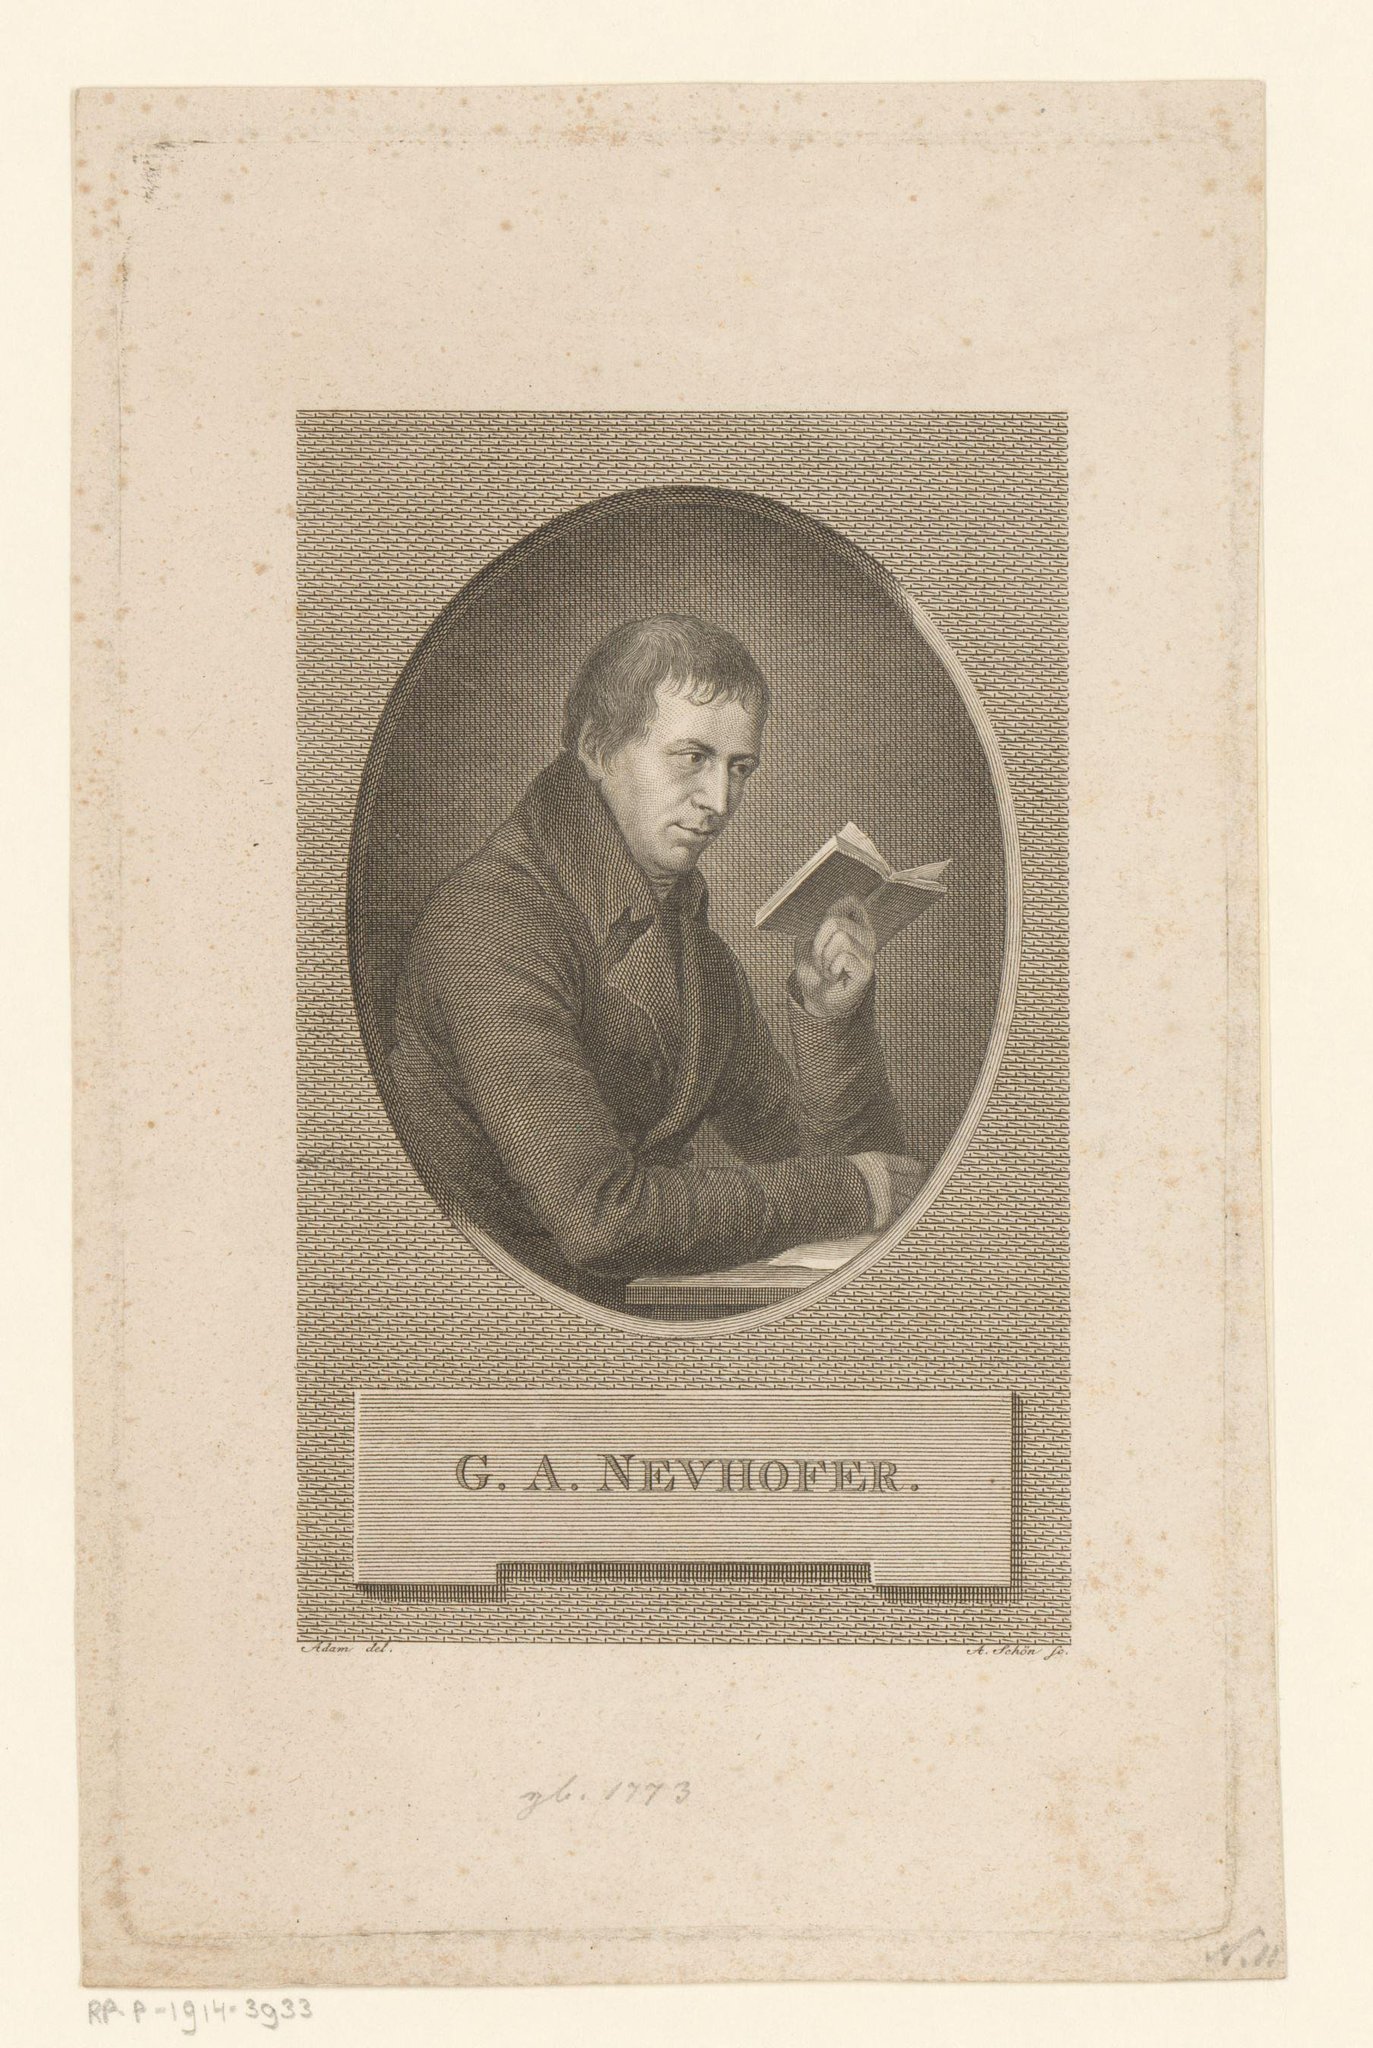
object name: print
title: Portret van Gerhard Adam Neuhofer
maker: alois schoen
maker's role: draughtsman, print maker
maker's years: -1820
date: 1720-1820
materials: paper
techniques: engraving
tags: augsburg, reading, historical persons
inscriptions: collector's mark: Lugt 2228